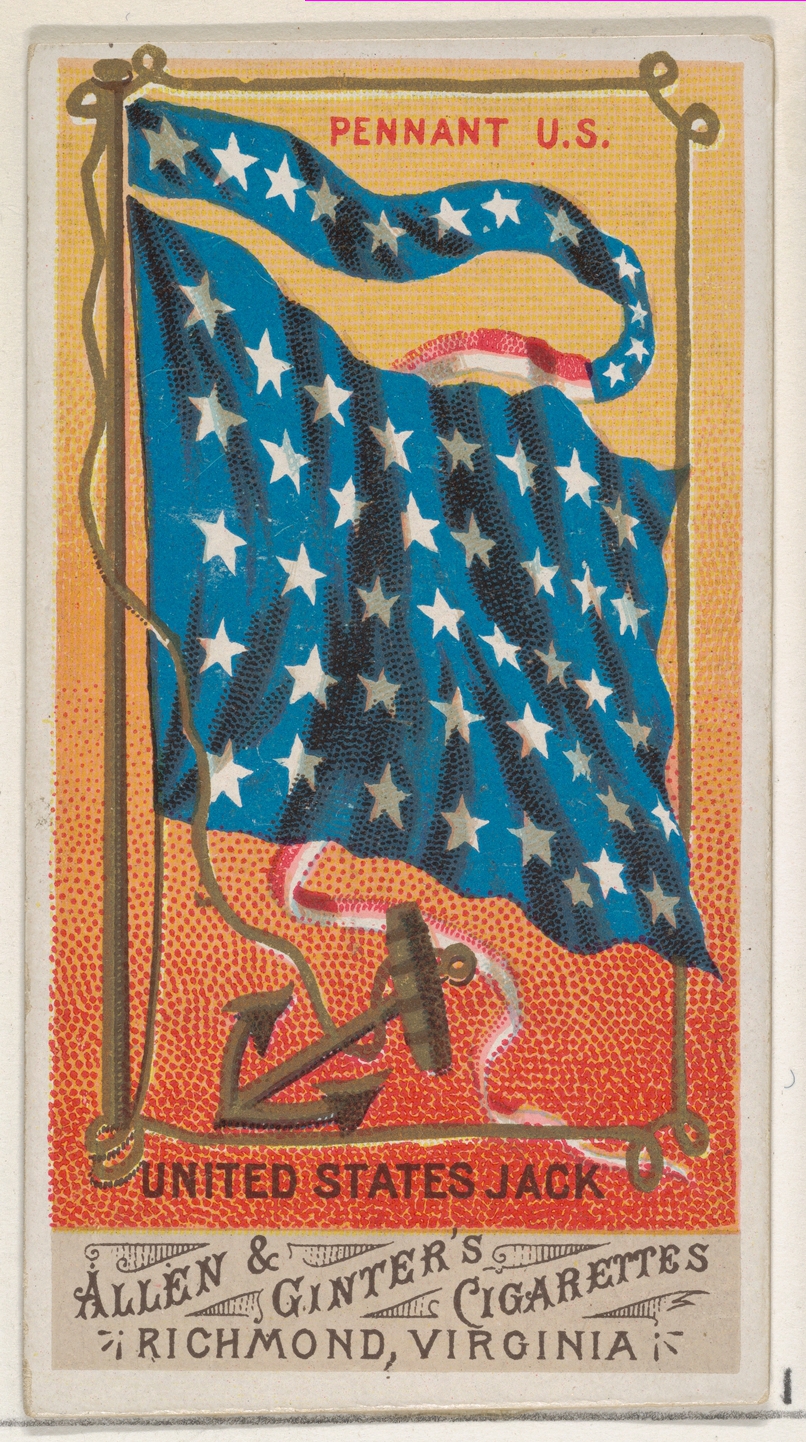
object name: print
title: Pennant U.S., United States Jack, from Flags of All Nations, Series 1 (N9) for Allen & Ginter Cigarettes Brands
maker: allen & ginter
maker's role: publisher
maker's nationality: american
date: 1887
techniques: color lithograph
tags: flags